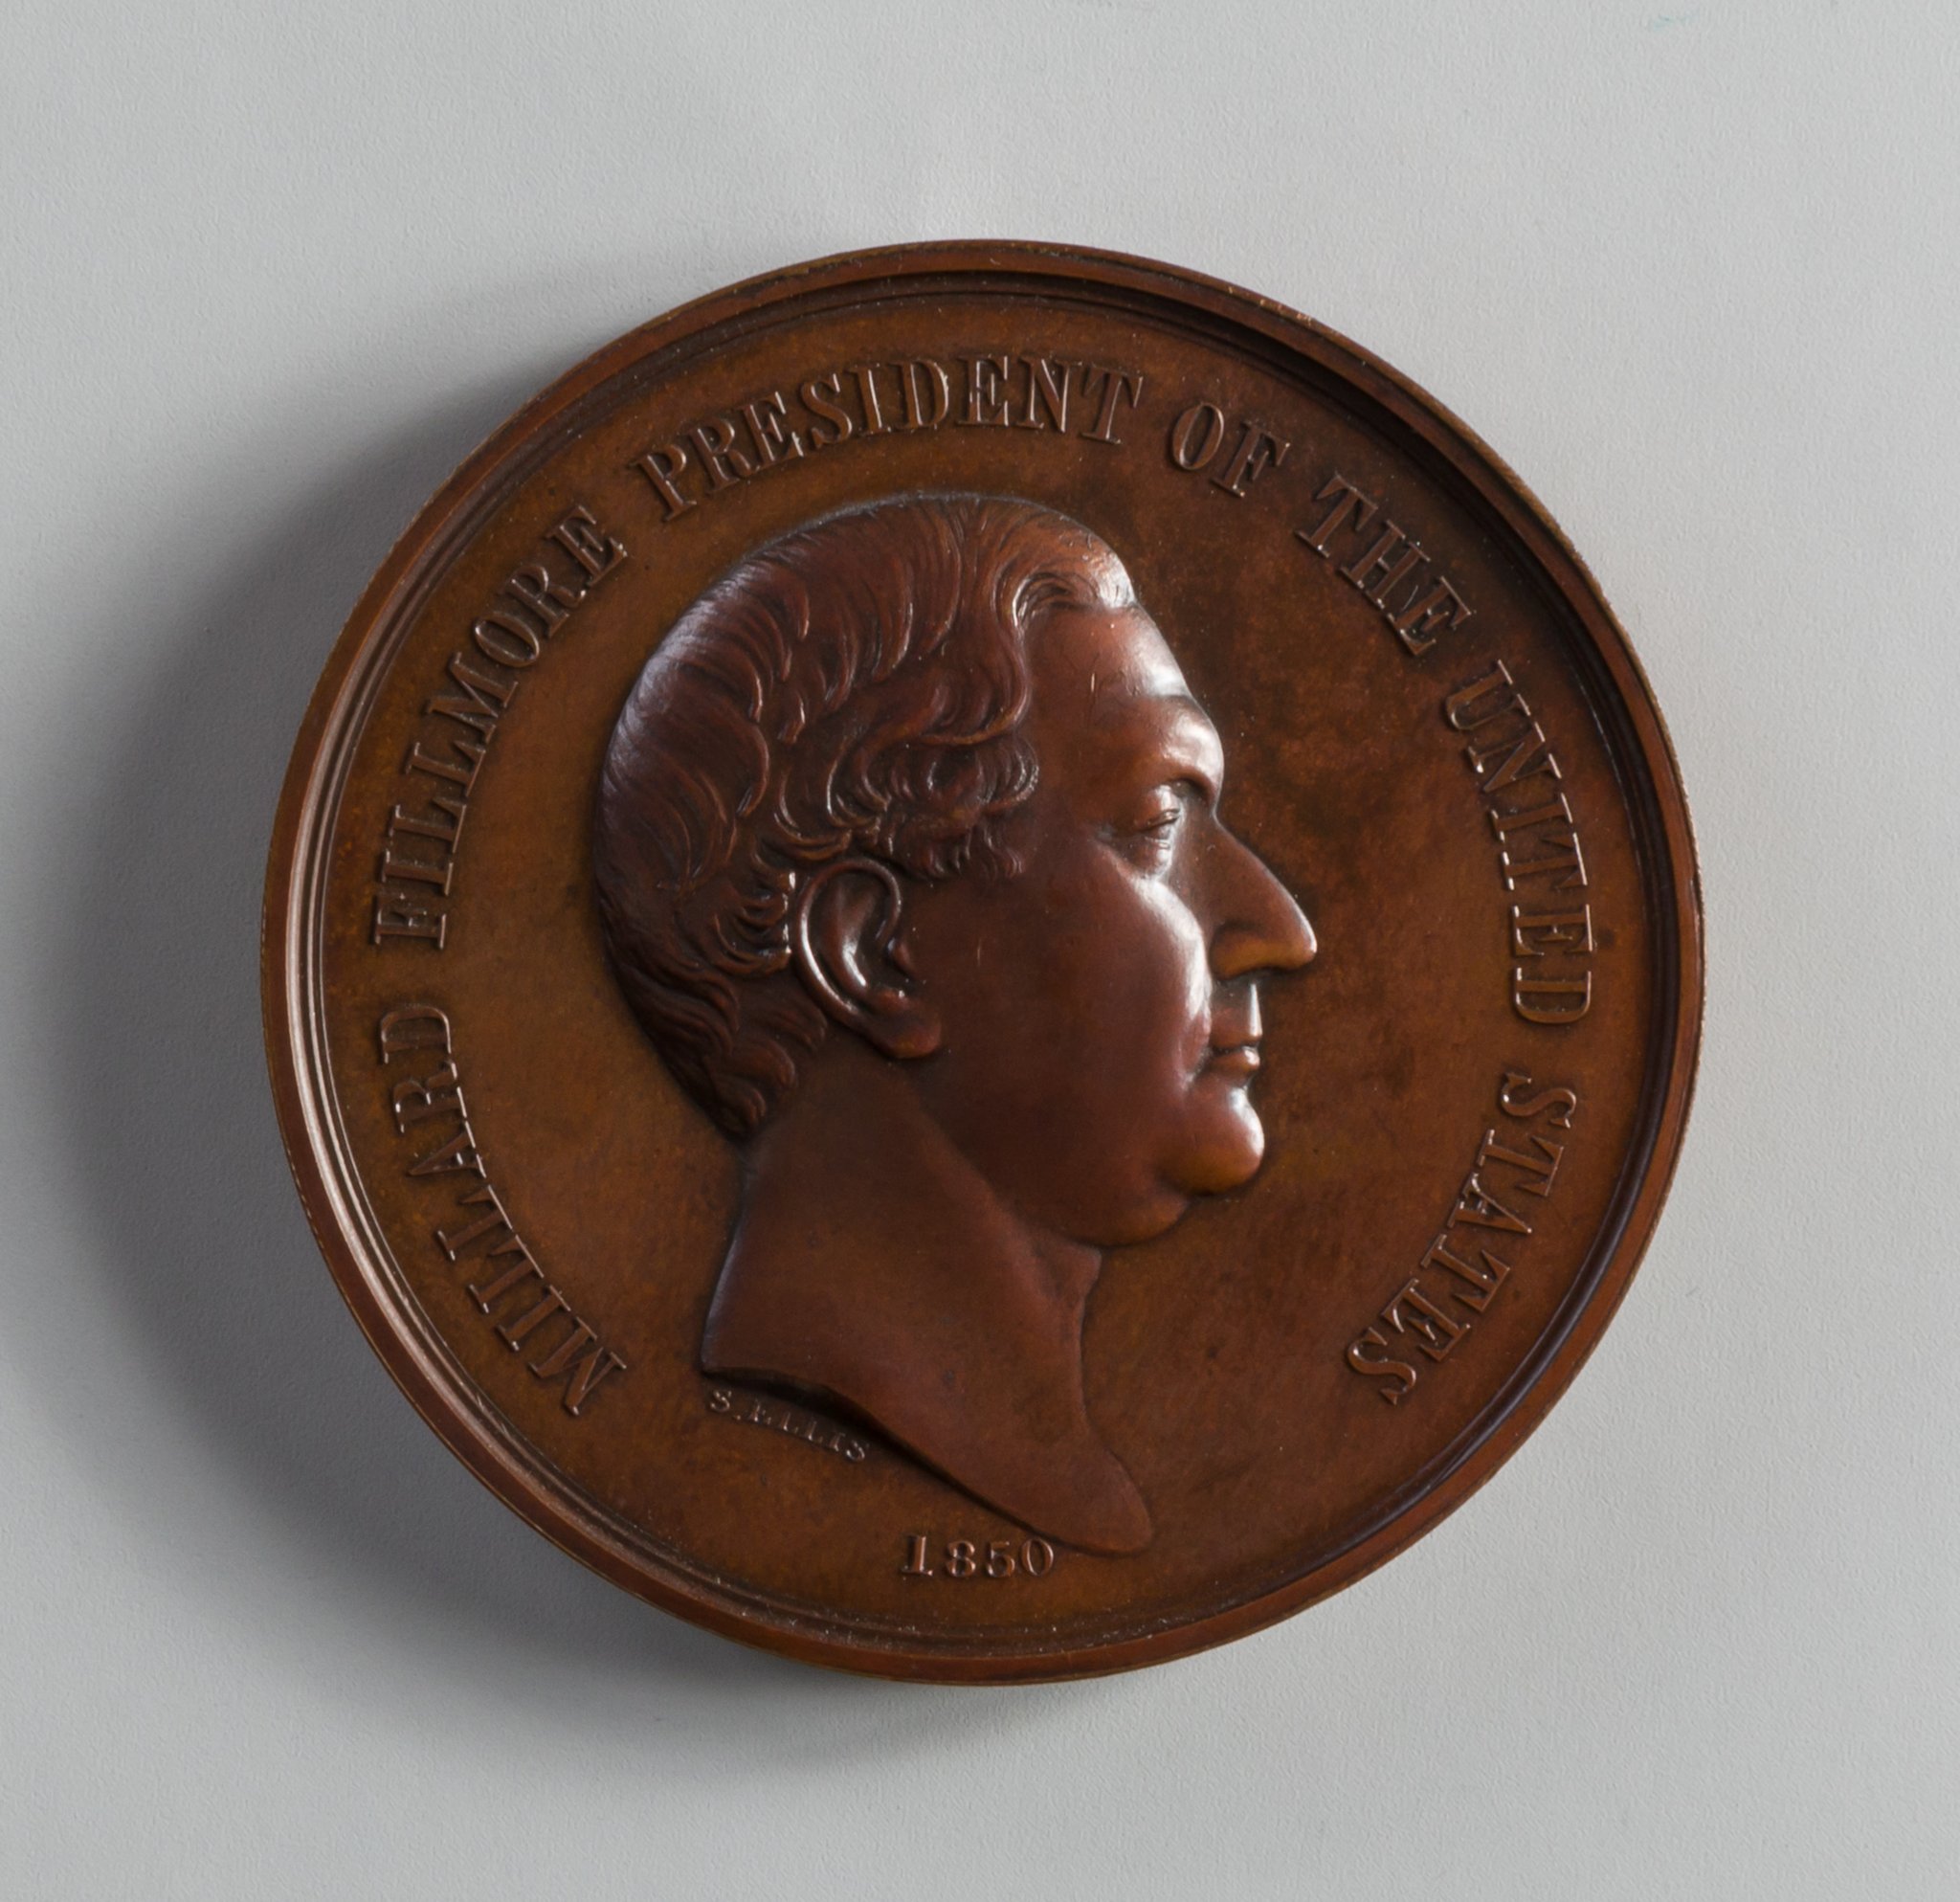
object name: medal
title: Medal of Millard Fillmore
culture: american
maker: salathiel ellis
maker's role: maker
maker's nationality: american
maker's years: 1803-1879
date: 1850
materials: bronze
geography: united states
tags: men,profiles